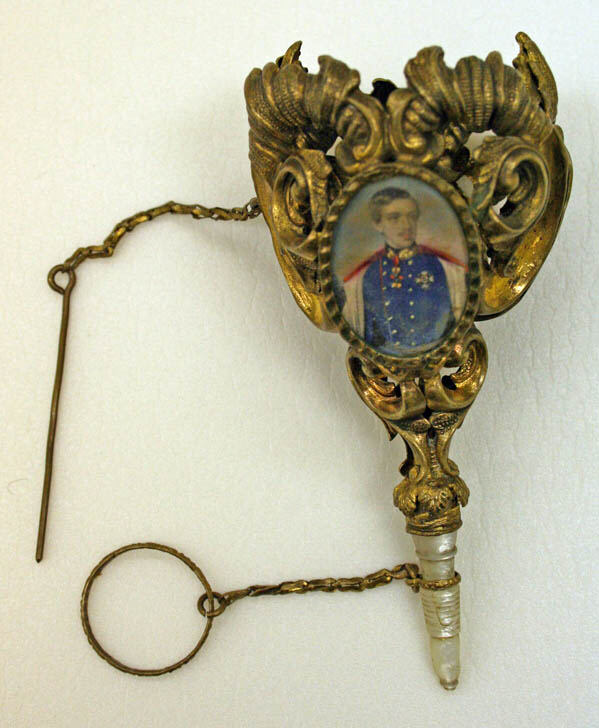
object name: bouquet holder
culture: american or european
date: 1854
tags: men,portraits,women